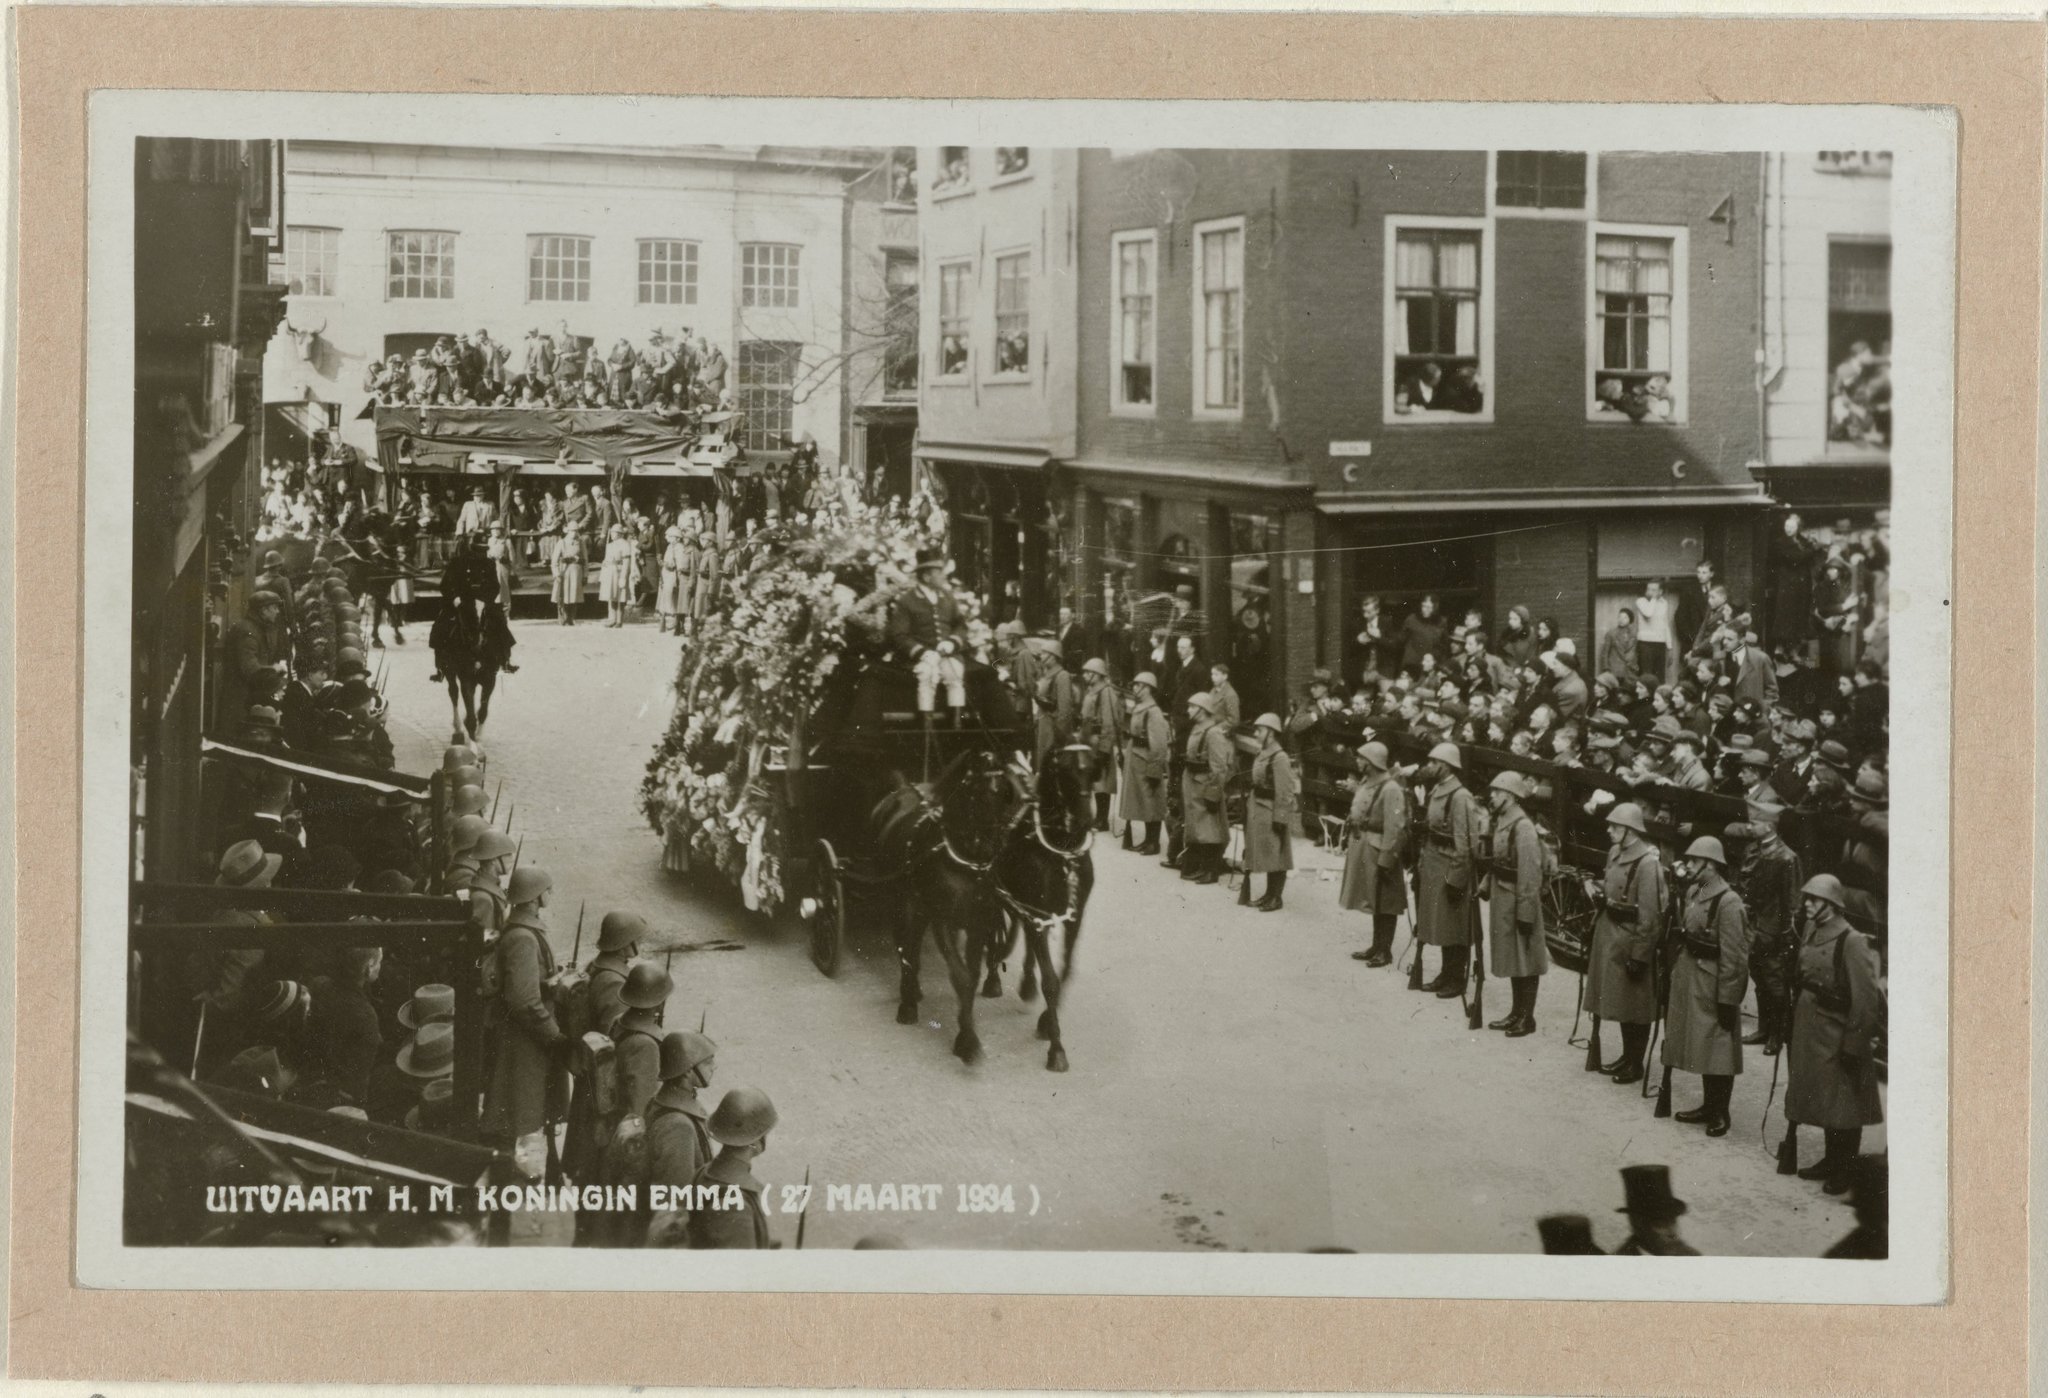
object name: photograph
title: Een bloemenwagen van de begrafenisstoet van Emma, koningin-regentes der Nederlanden, te Delft op 27 maart 1934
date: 1934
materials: photographic support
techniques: photography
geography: netherlands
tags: emma (queen consort of the netherlands), cortege, funeral procession, delft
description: Een bloemenwagen van de begrafenisstoet van Emma te Delft op 27 maart 1934. Eronder een regel Nederlandse tekst.